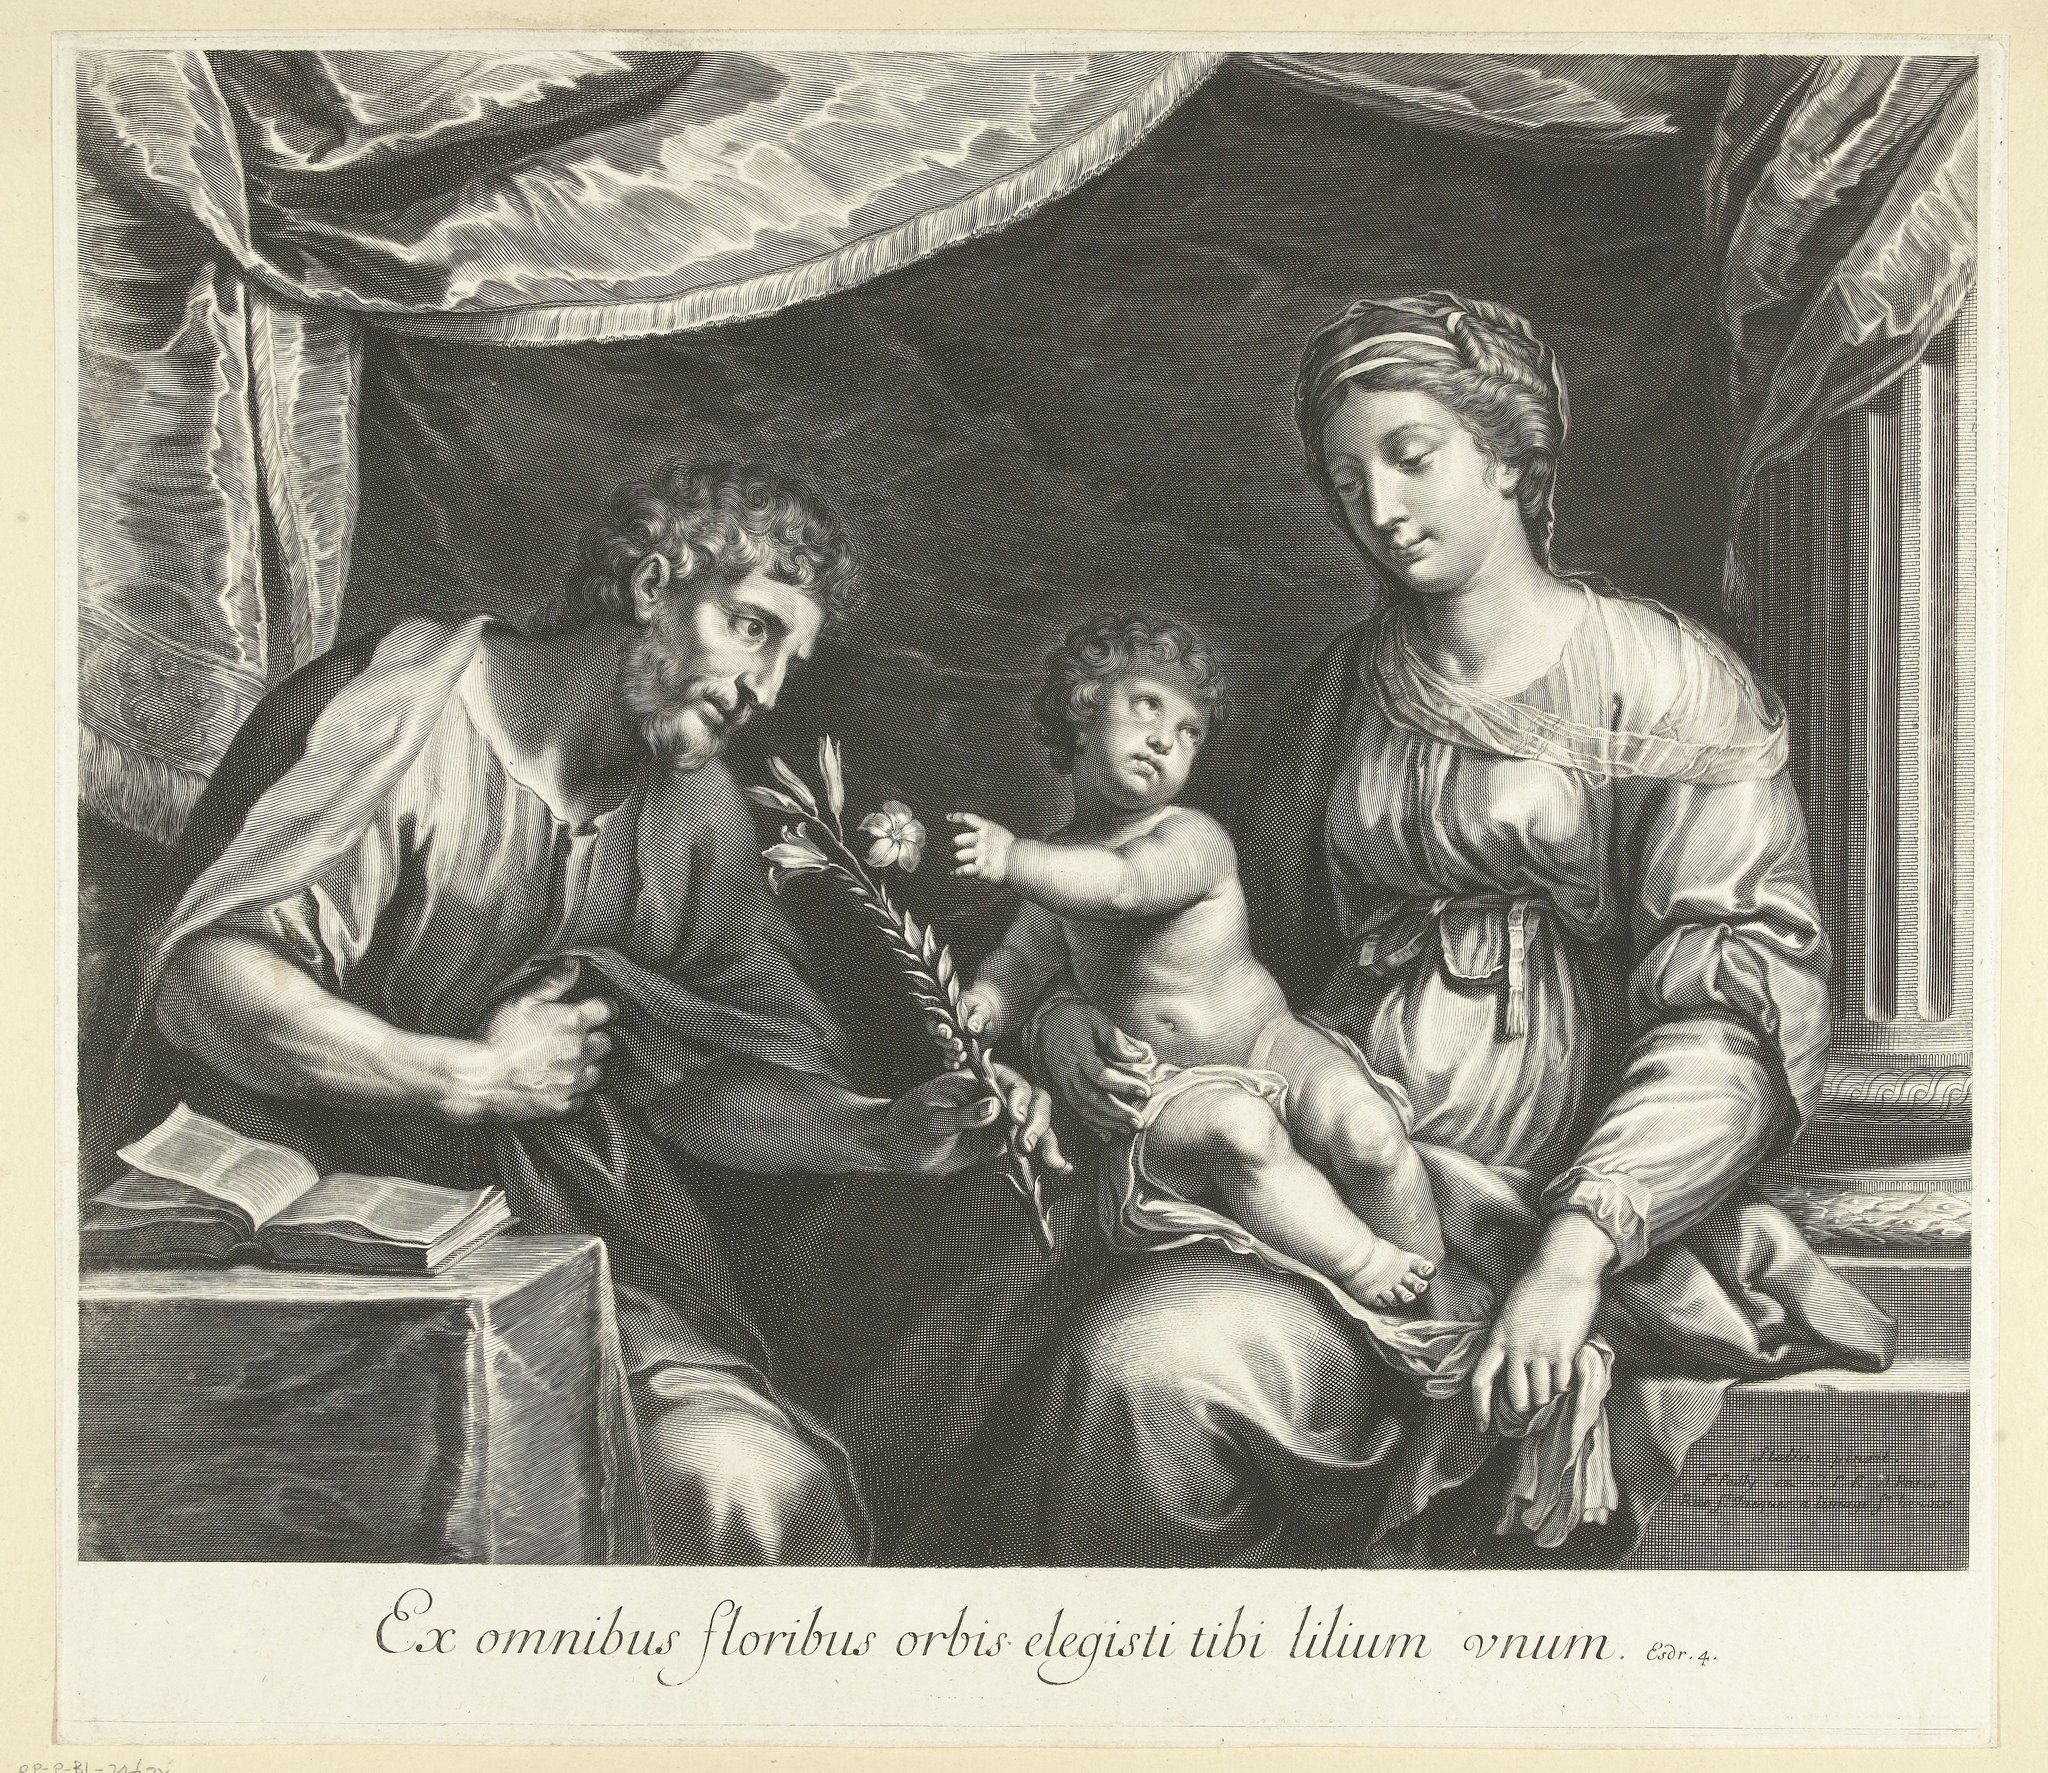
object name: print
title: Heilige familie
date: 1666-1707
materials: paper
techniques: engraving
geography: paris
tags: holy family, and derived representations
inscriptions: collector's mark: Lugt 240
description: Het Christuskind, op de schoot van Maria, wijst naar een bloem die Jozef hem toont. Onder de voorstelling een onderschrift in Latijn.